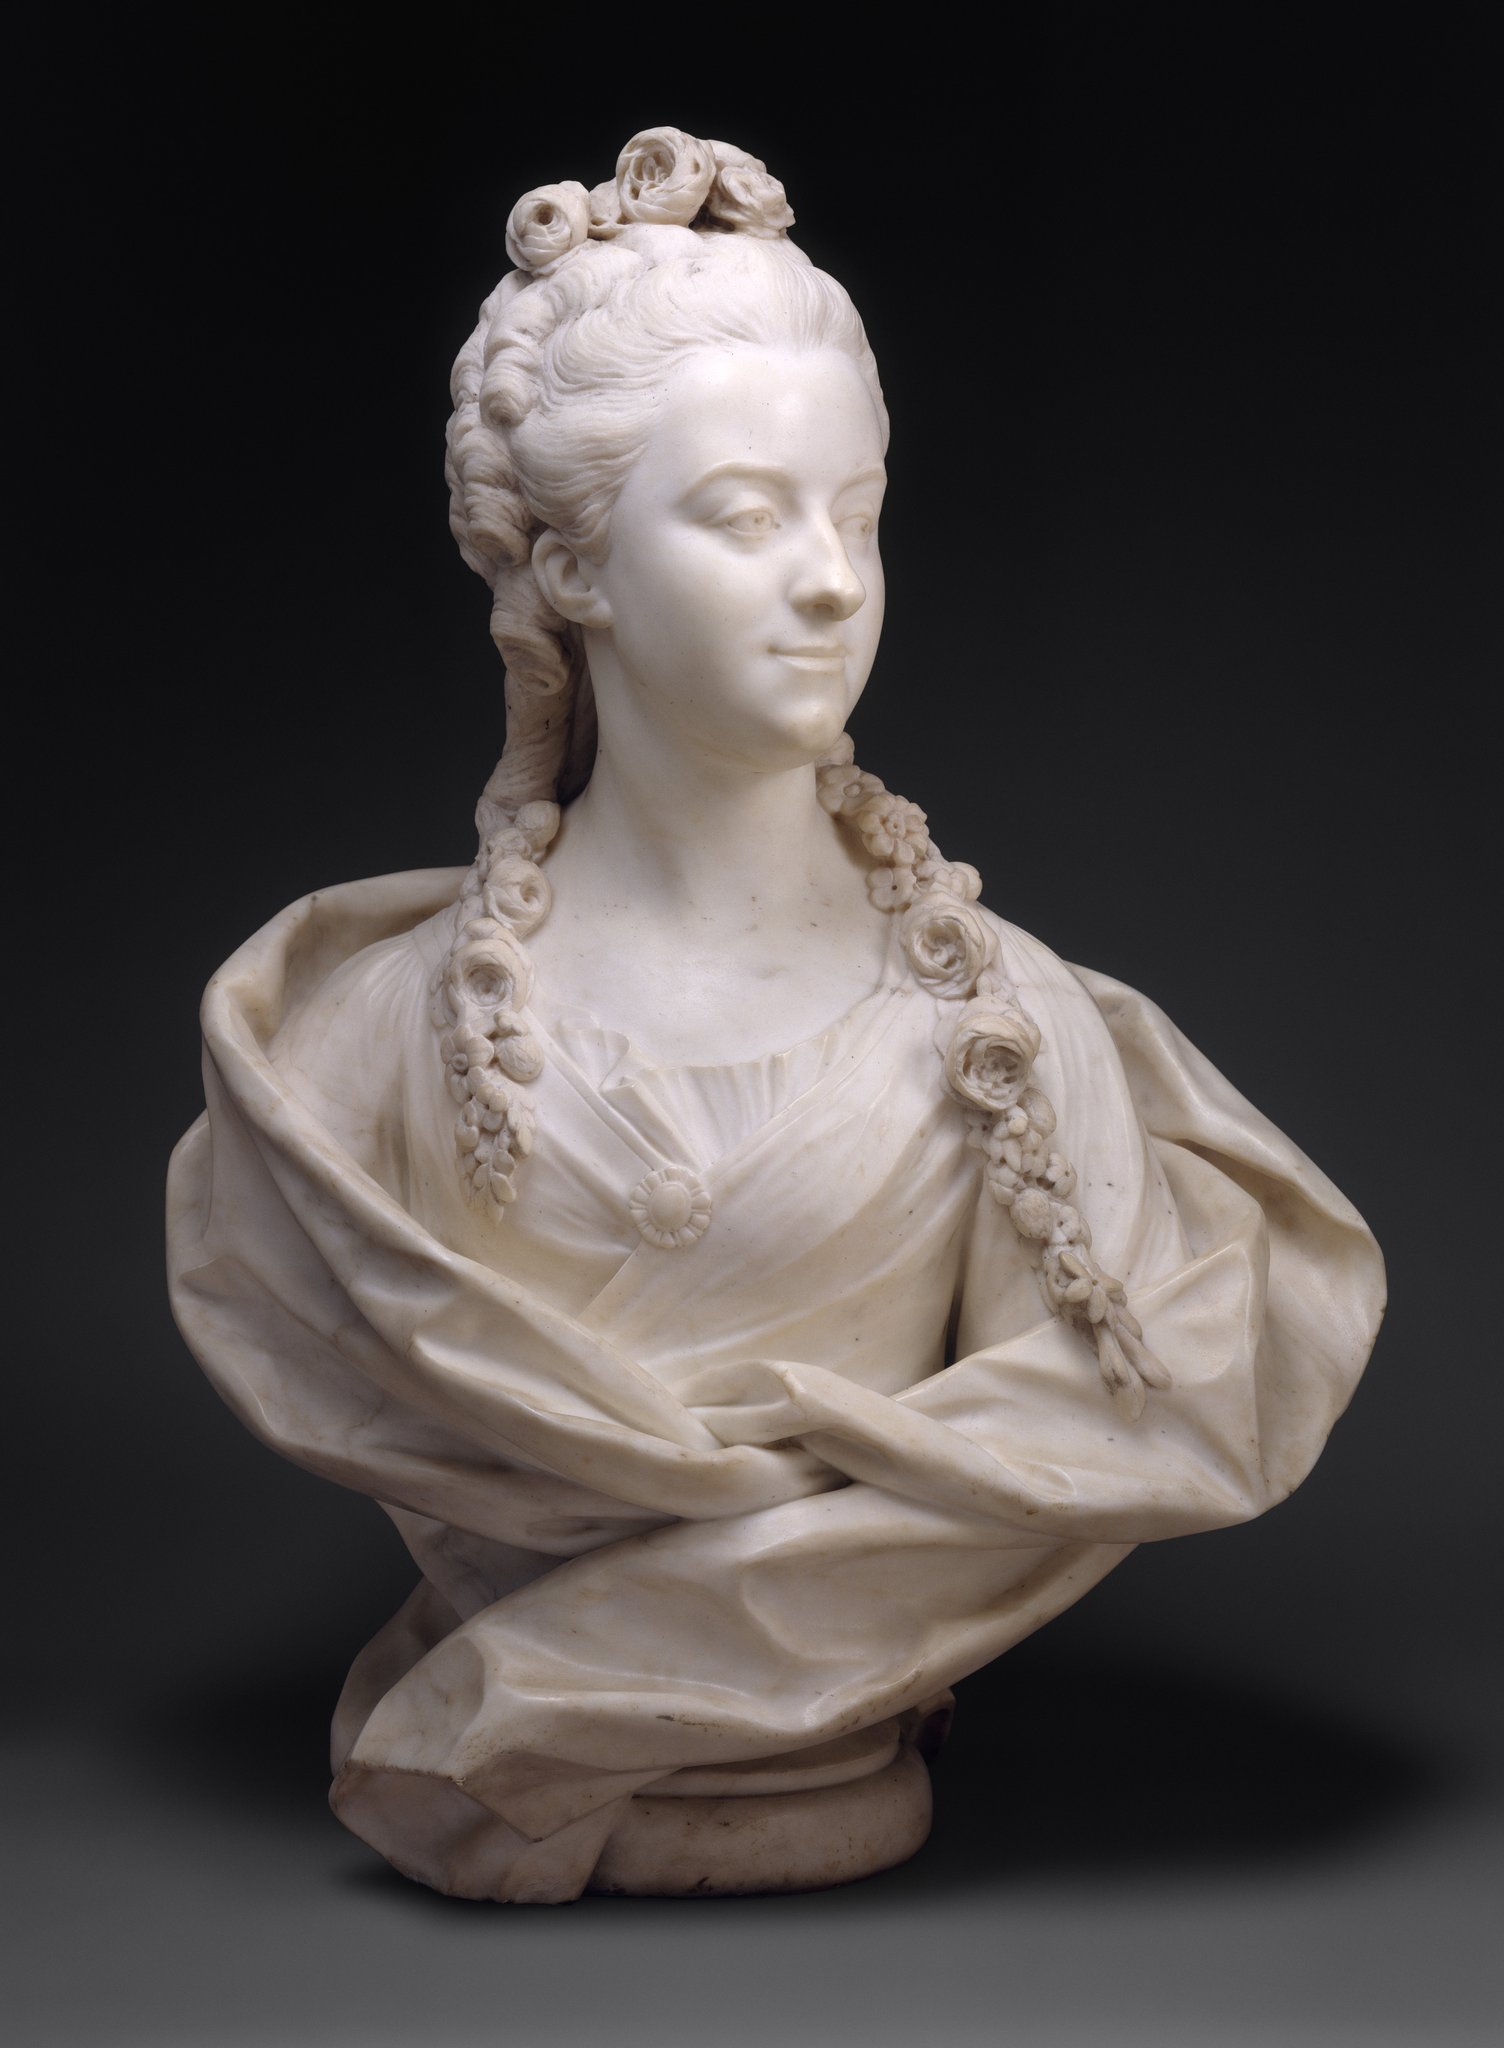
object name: bust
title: Geneviève-Françoise Randon de Malboissière (1740–1766)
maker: jean-baptiste lemoyne the younger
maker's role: artist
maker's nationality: french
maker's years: 1704-1778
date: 1768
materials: marble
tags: portraits,women